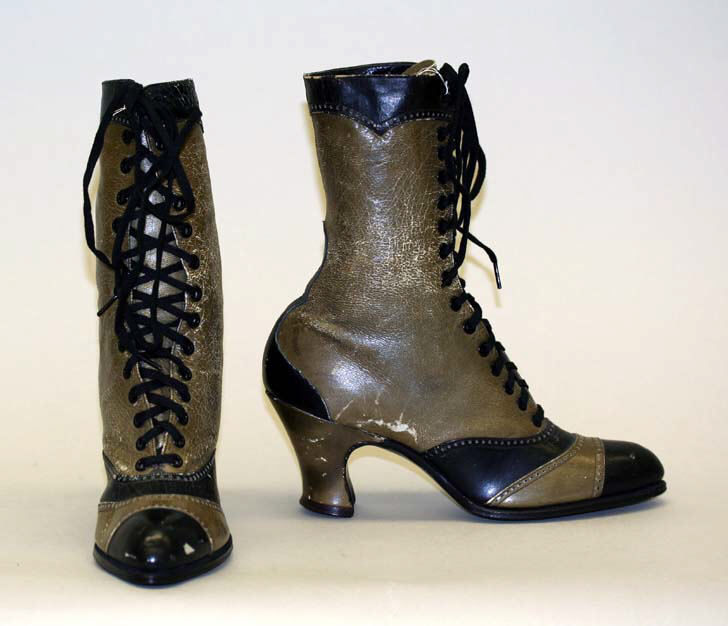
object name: boot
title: Boots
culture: american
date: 1900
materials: leather